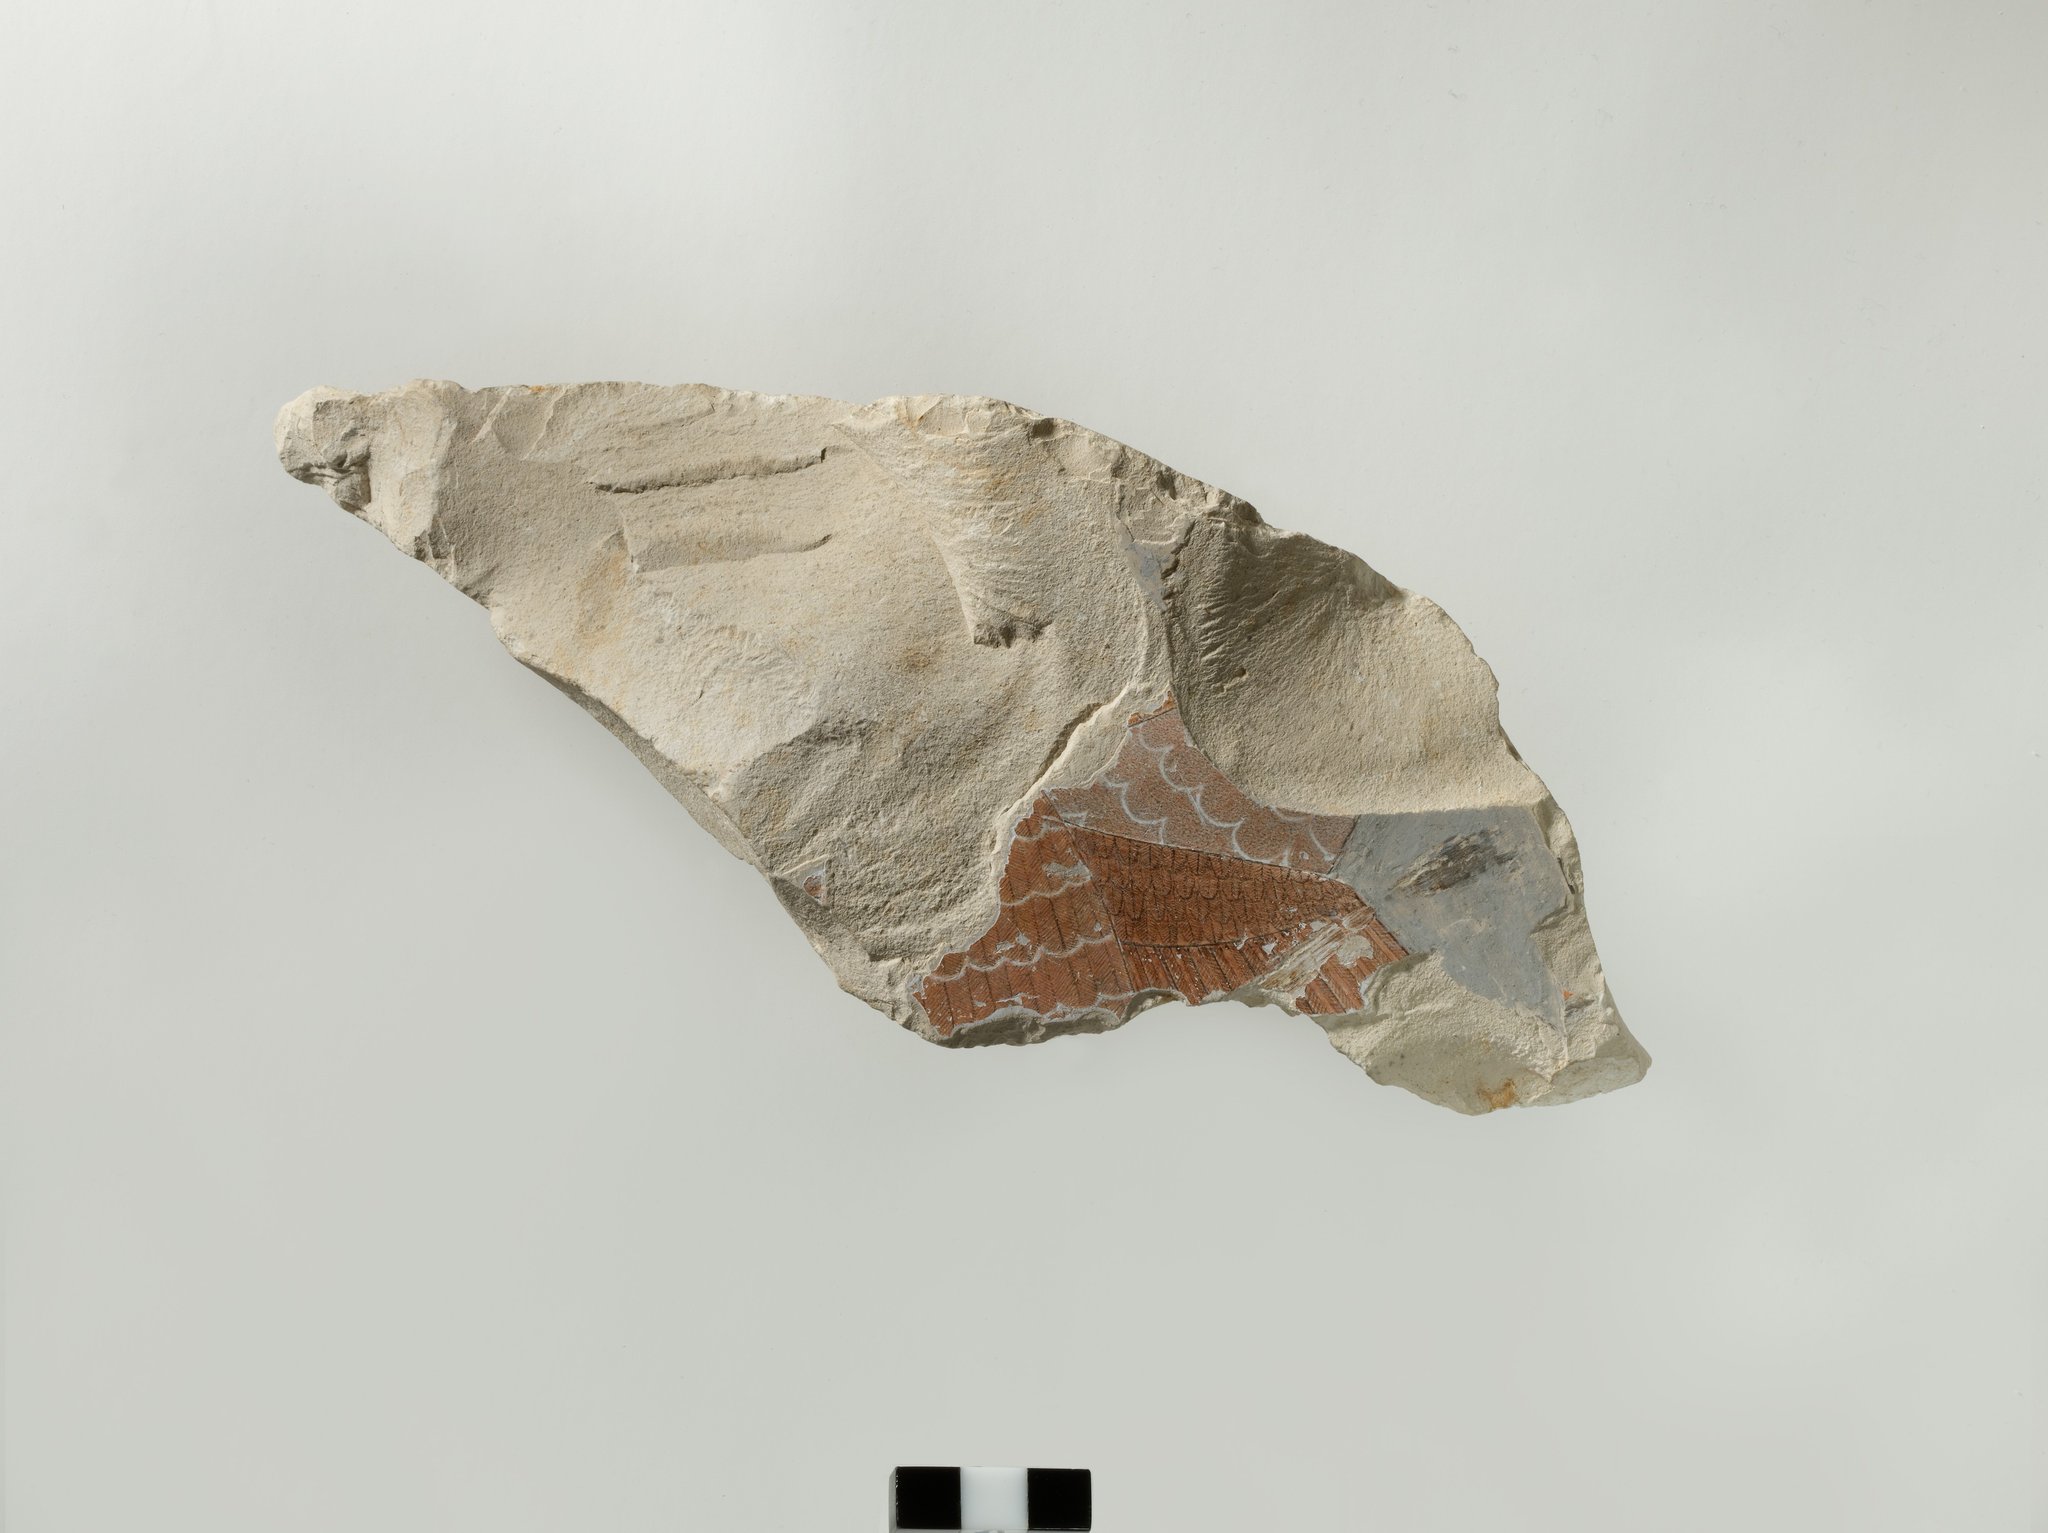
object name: relief fragment, tomb of meketre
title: Relief fragment from the tomb of Meketre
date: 1981-1975 BCE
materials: limestone, paint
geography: egypt